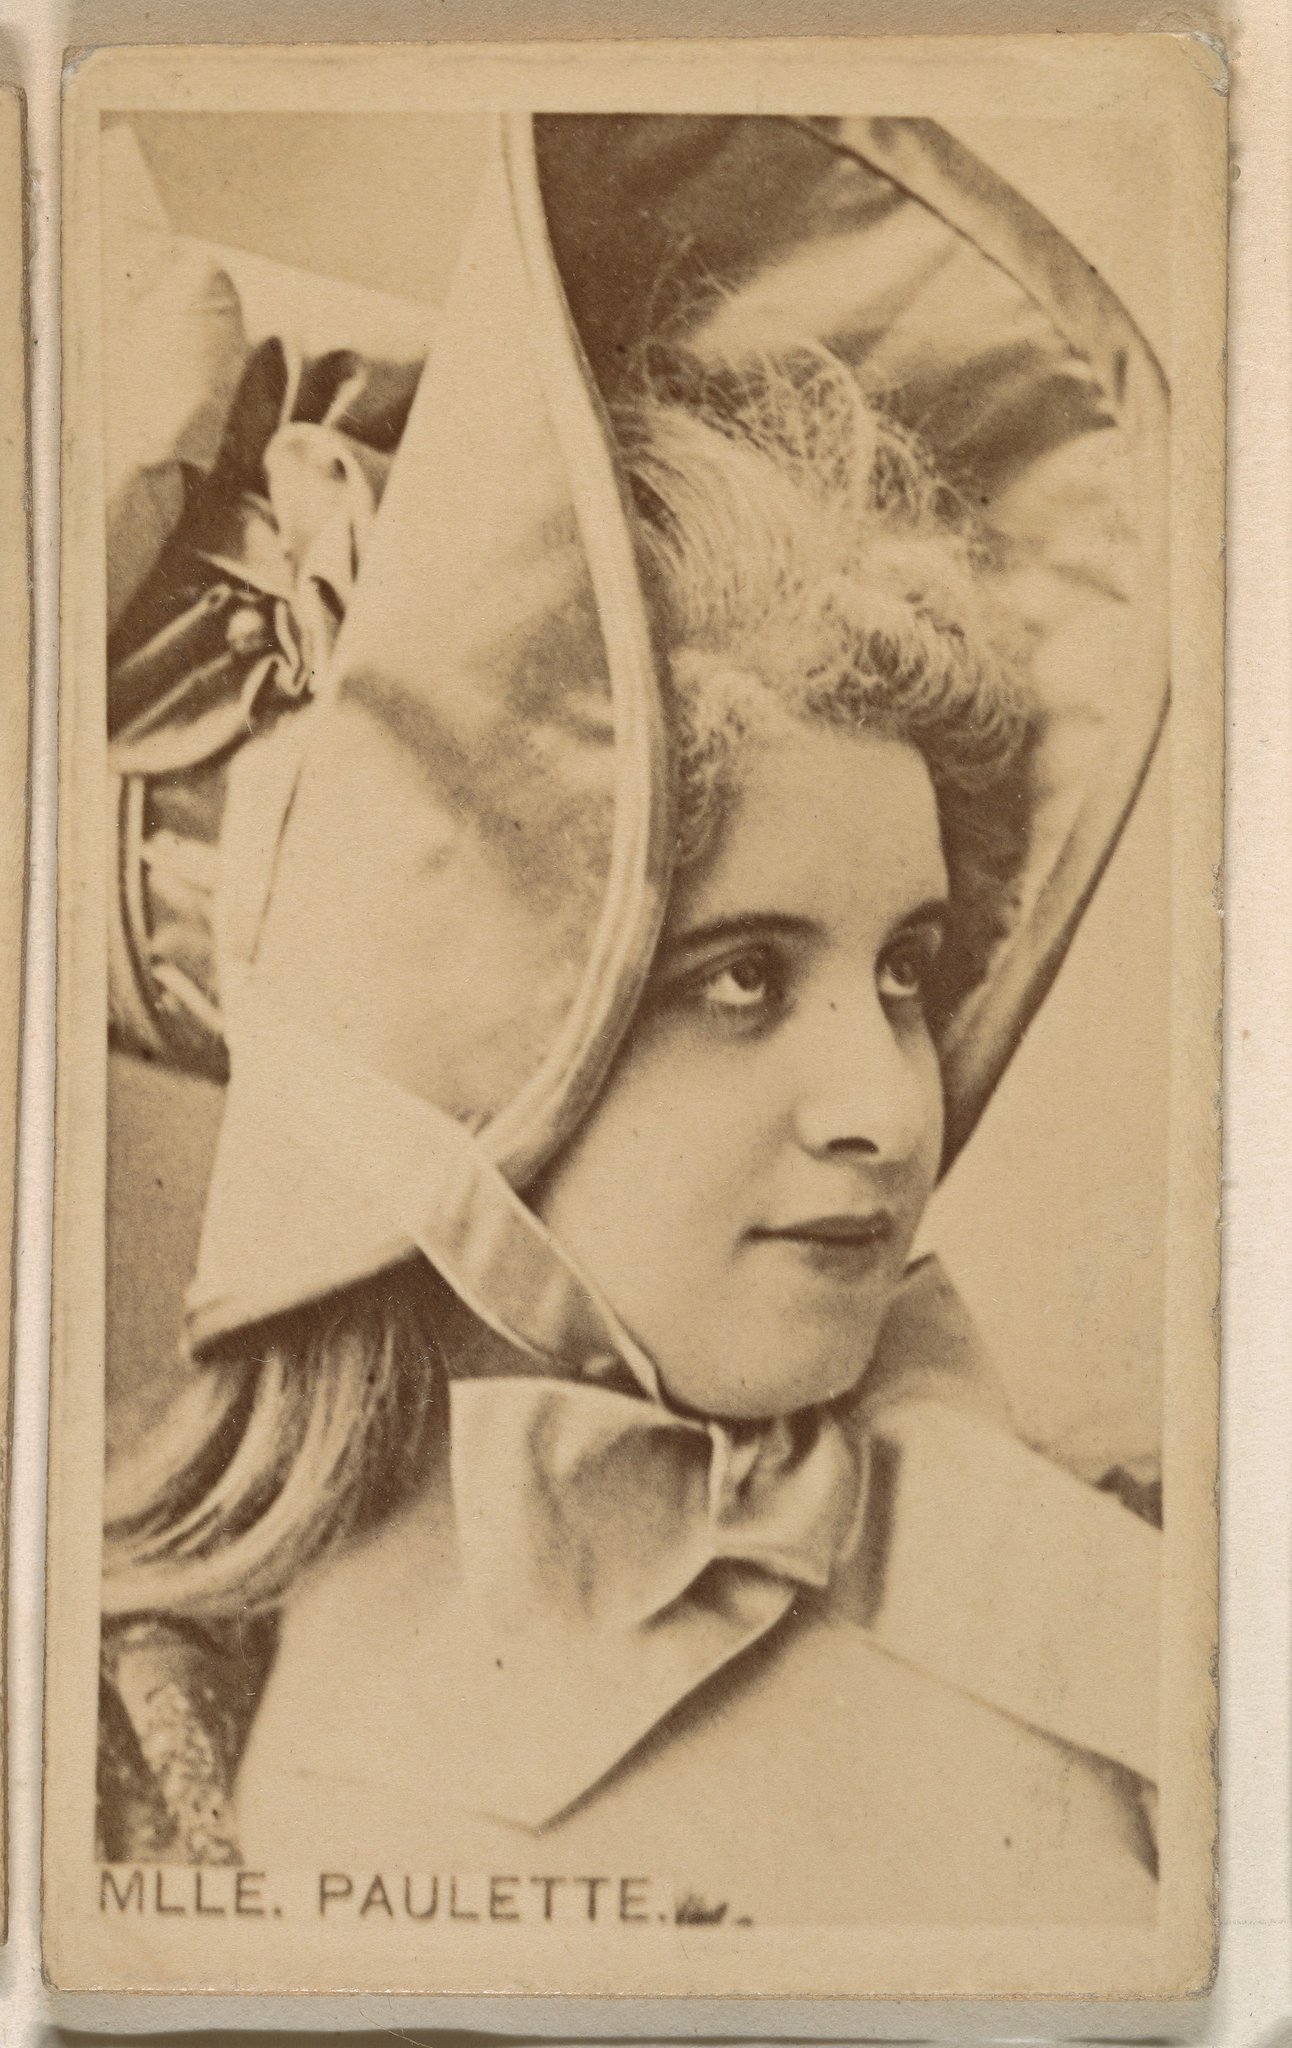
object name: photograph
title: Mlle. Paulette, from the Actresses series (N246), Type 1, issued by Kinney Brothers to promote Sporting Extra Cigarettes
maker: kinney brothers tobacco company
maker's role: publisher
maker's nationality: american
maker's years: 1869-2011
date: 1890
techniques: albumen silver print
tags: portraits,women,actresses